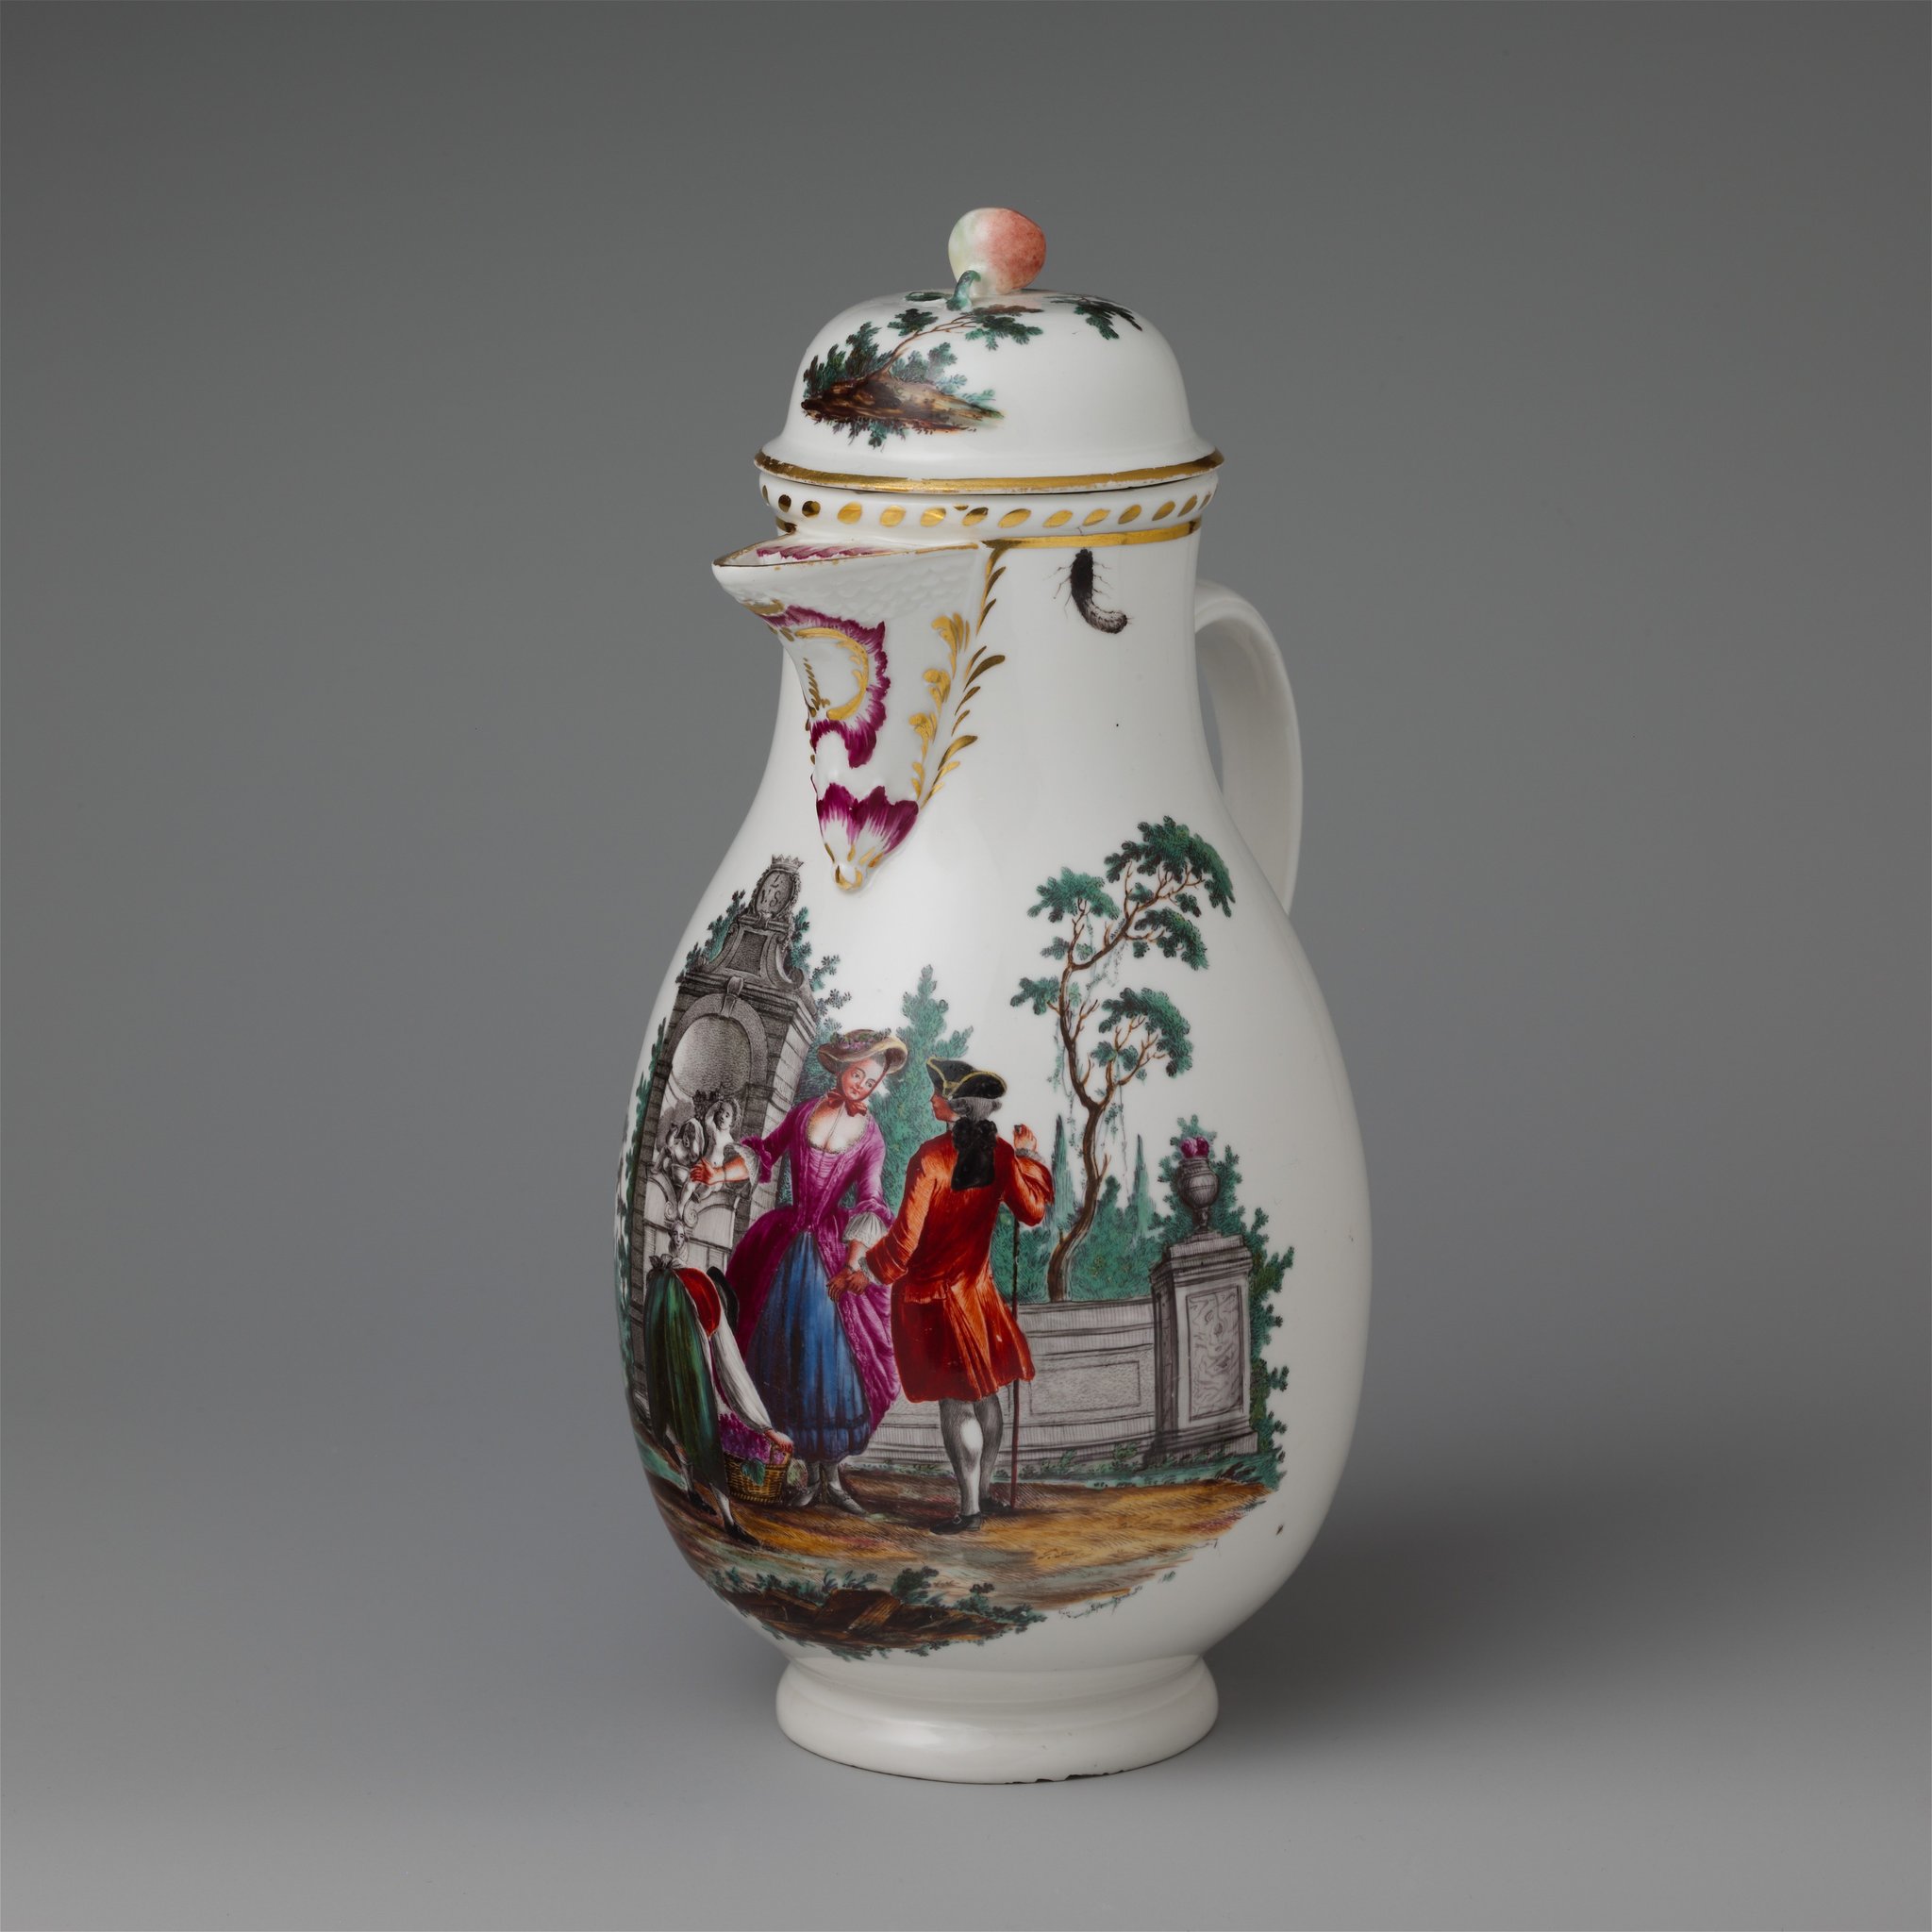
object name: coffeepot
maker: höchst manufactory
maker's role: manufactory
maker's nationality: german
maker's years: 1746-1796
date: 1773-1775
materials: enamel, gold, hard paste porcelain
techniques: polychrome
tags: men,women